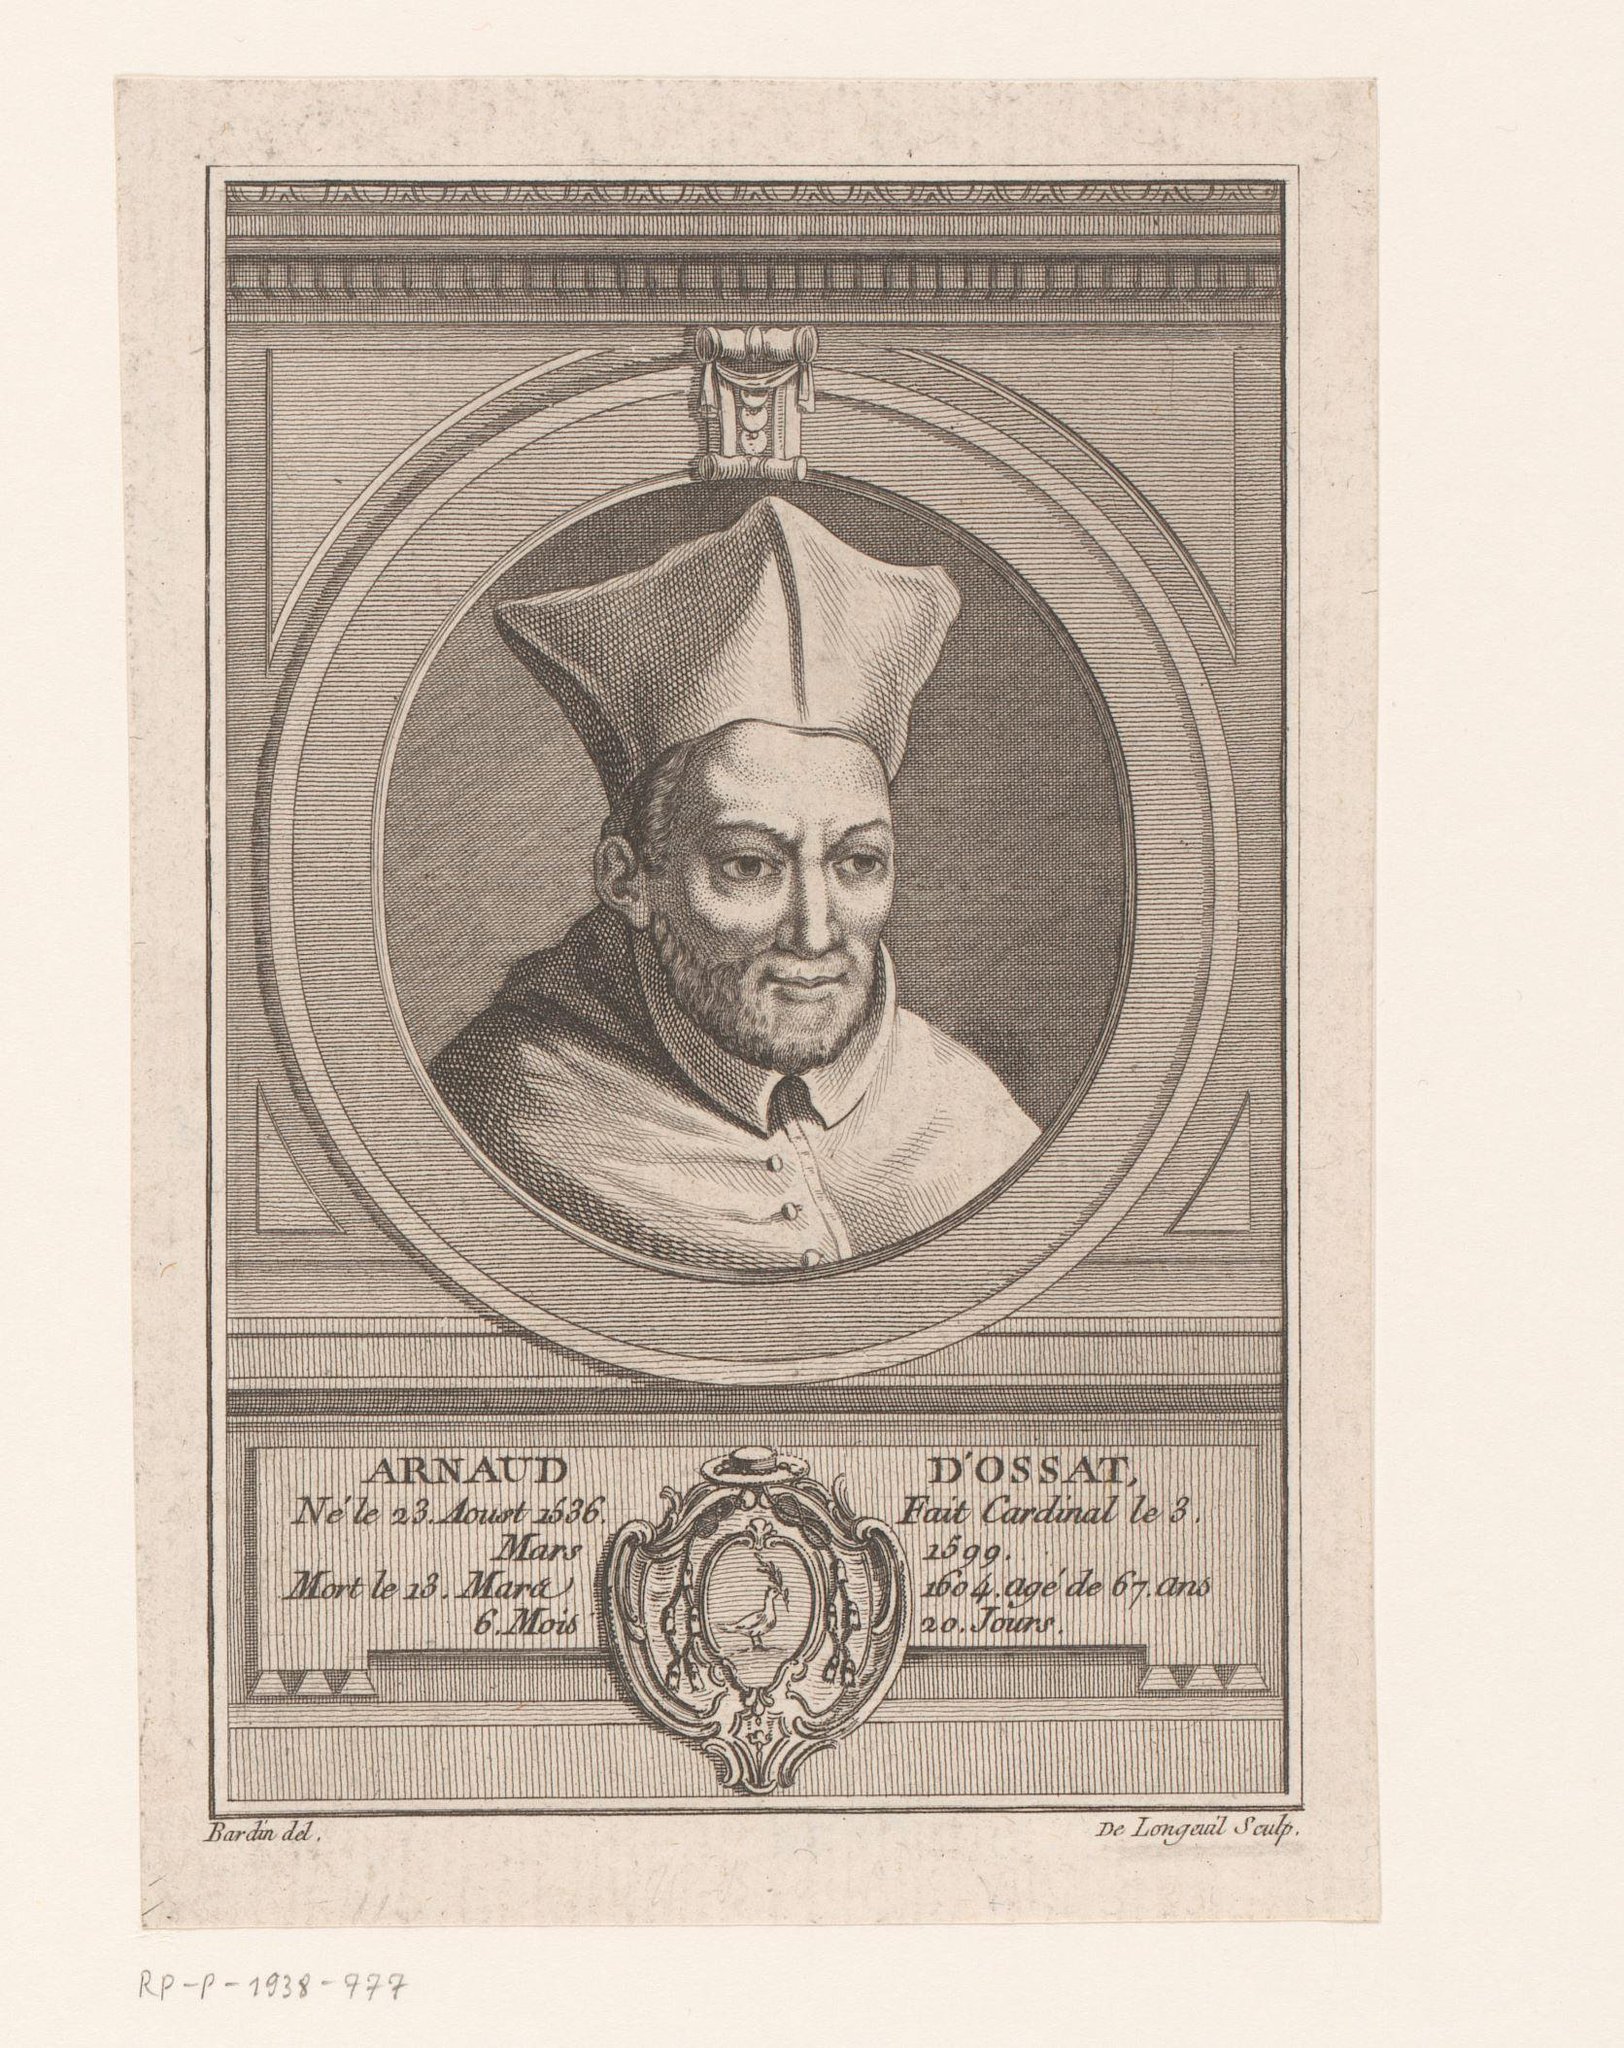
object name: print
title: Portret van Arnaud d'Ossat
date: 1740-1792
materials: paper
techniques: engraving, etching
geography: france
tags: france, rome, cardinal, historical persons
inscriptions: collector's mark: Lugt 2228